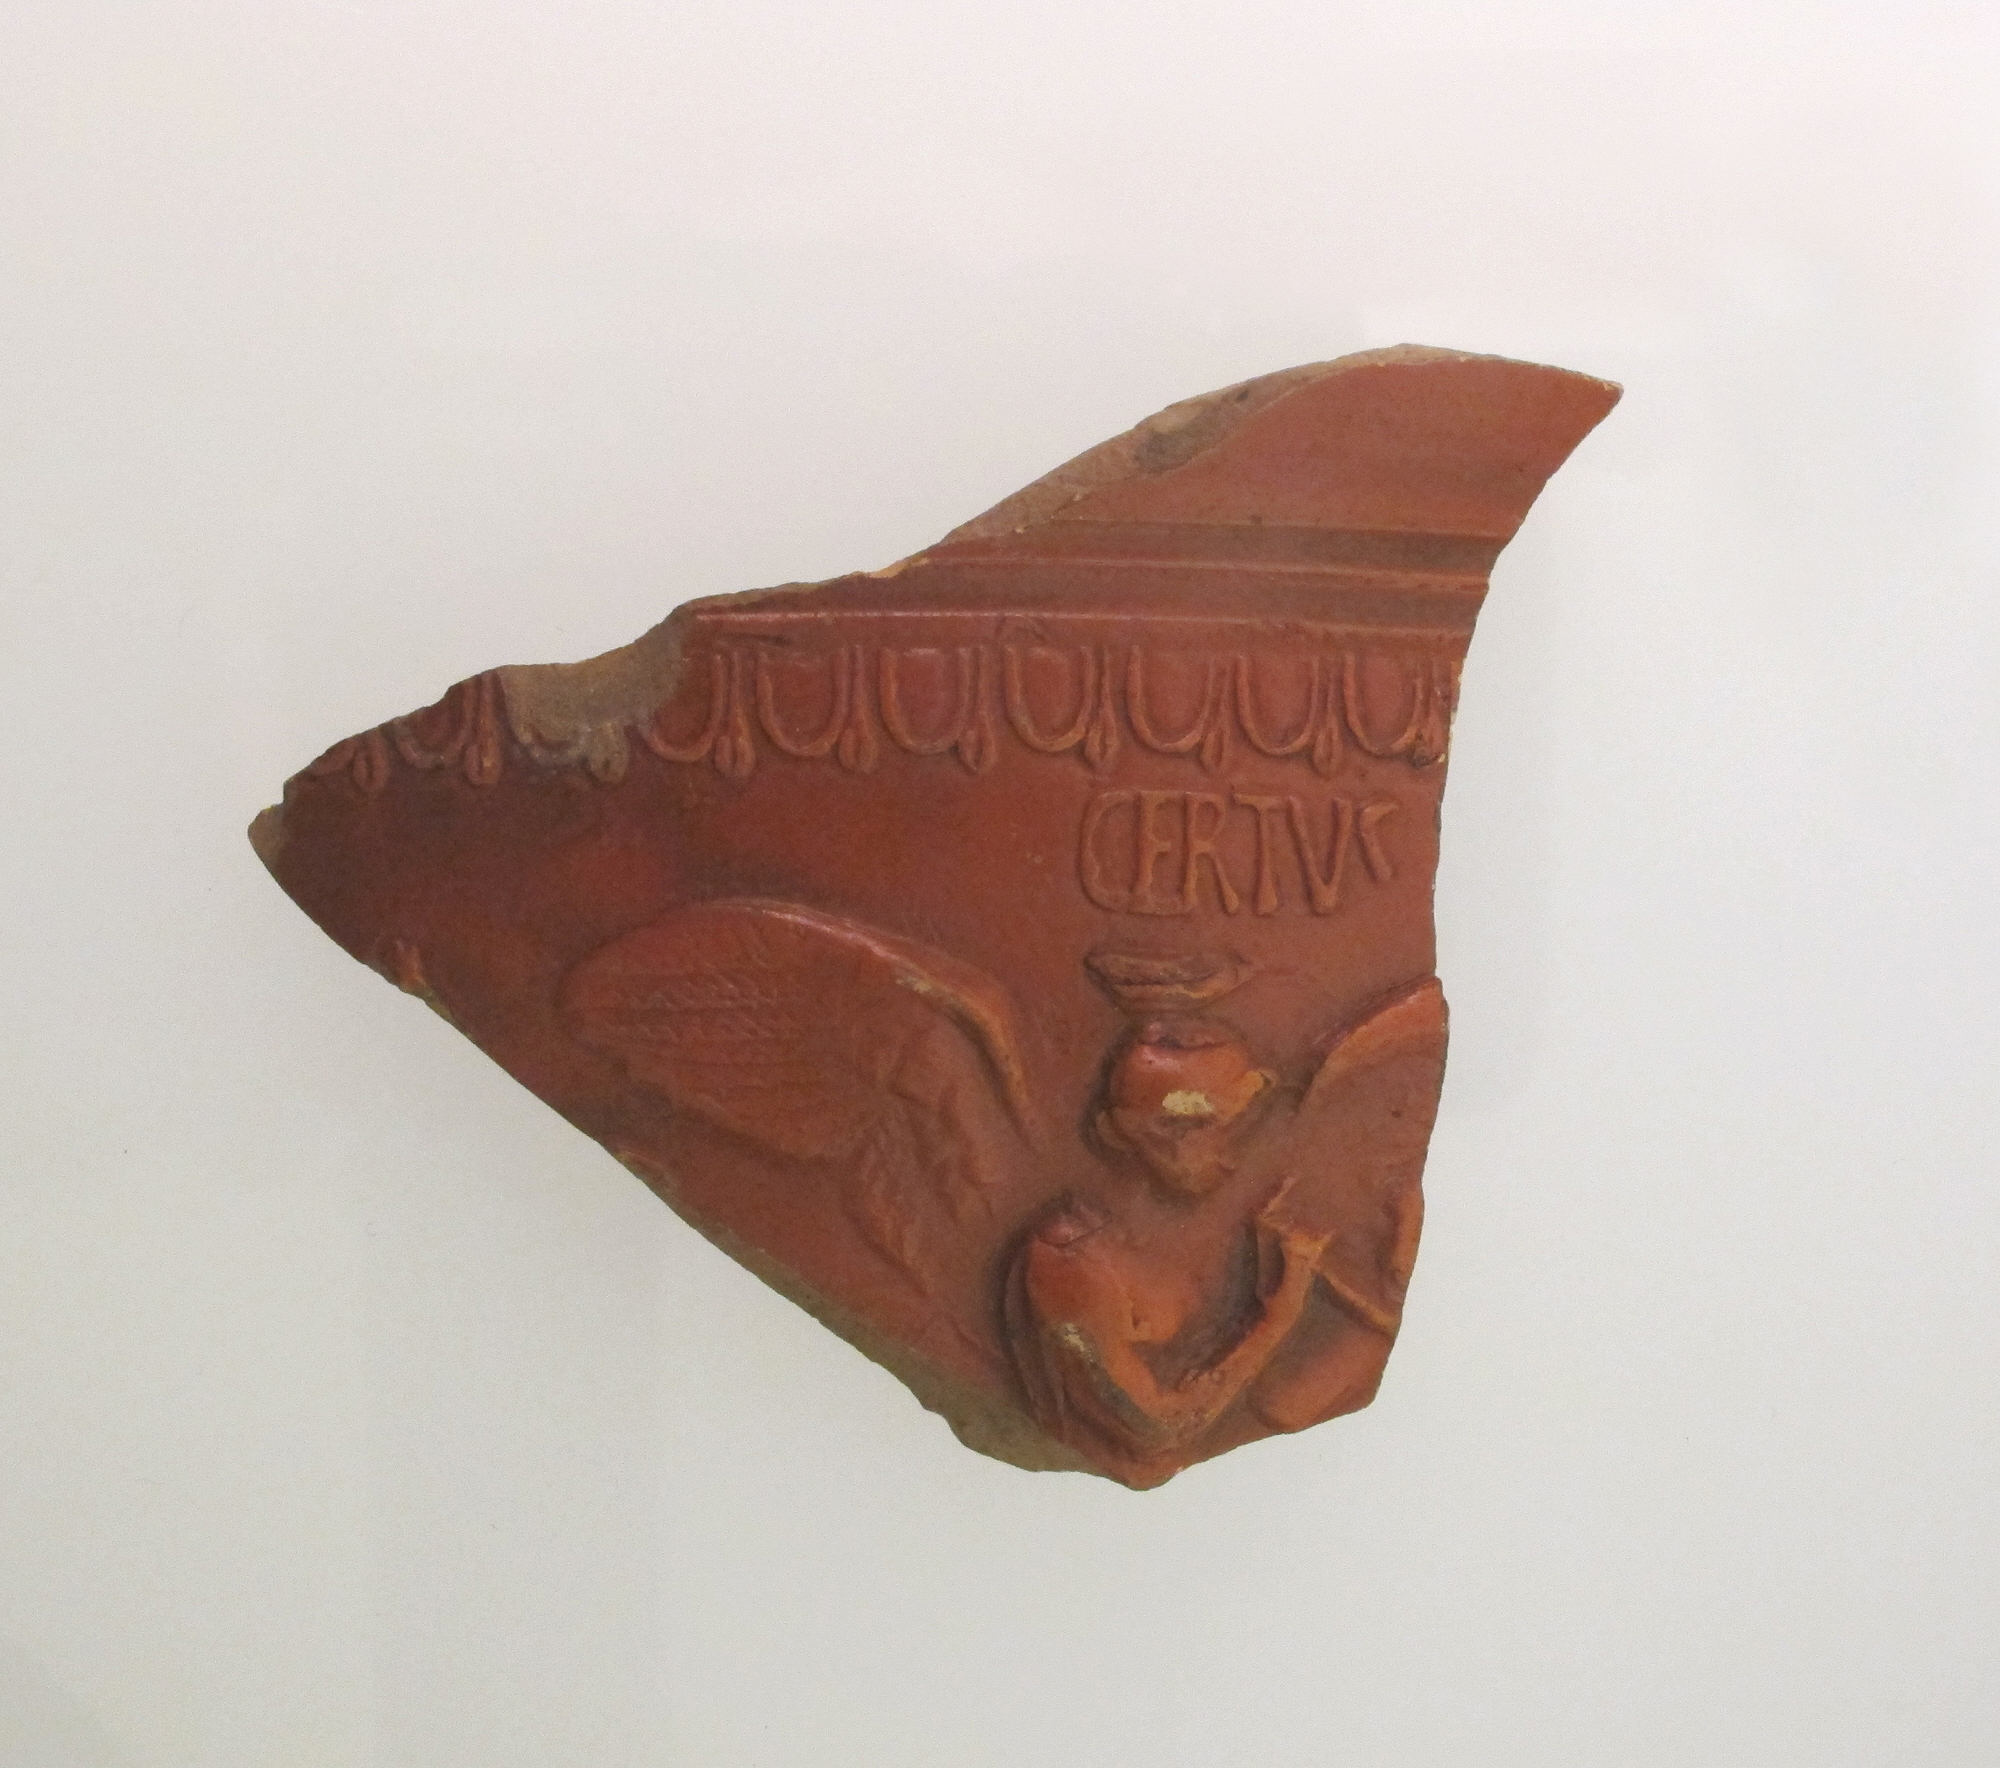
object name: vase fragment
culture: roman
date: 100 BCE-100 CE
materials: terracotta